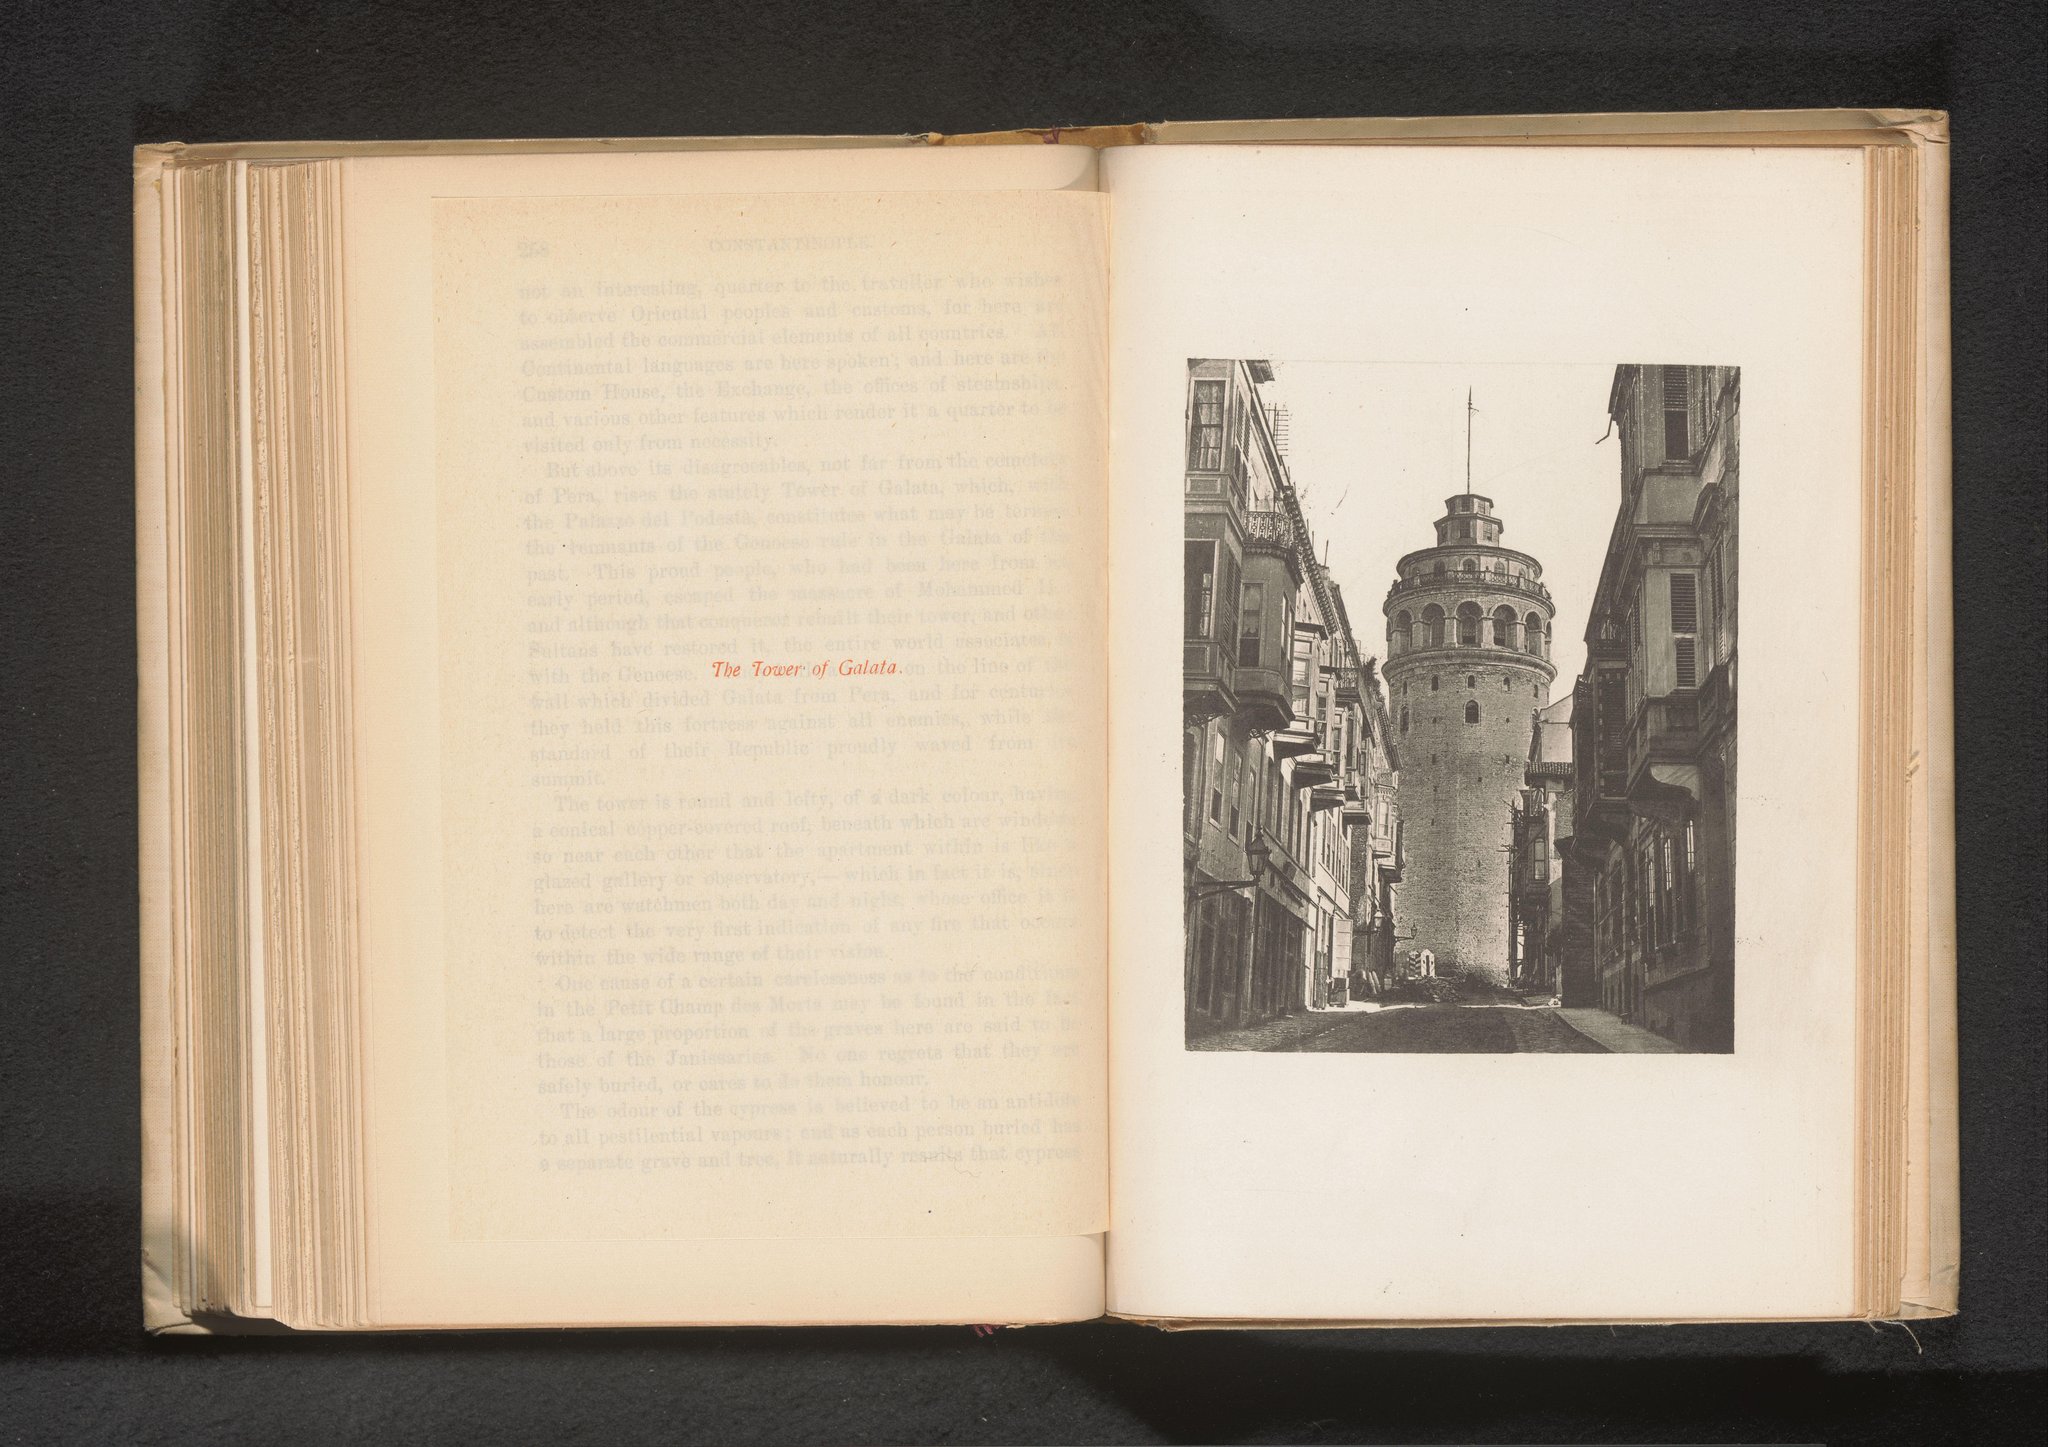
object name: photomechanical print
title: Gezicht op de Galatatoren te Constantinopel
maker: Anonymous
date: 1885-1895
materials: paper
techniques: photoaquatint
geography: constantinople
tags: tower, clock tower ~ monumental adornment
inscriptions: title: ‘The Tower of Galata.’